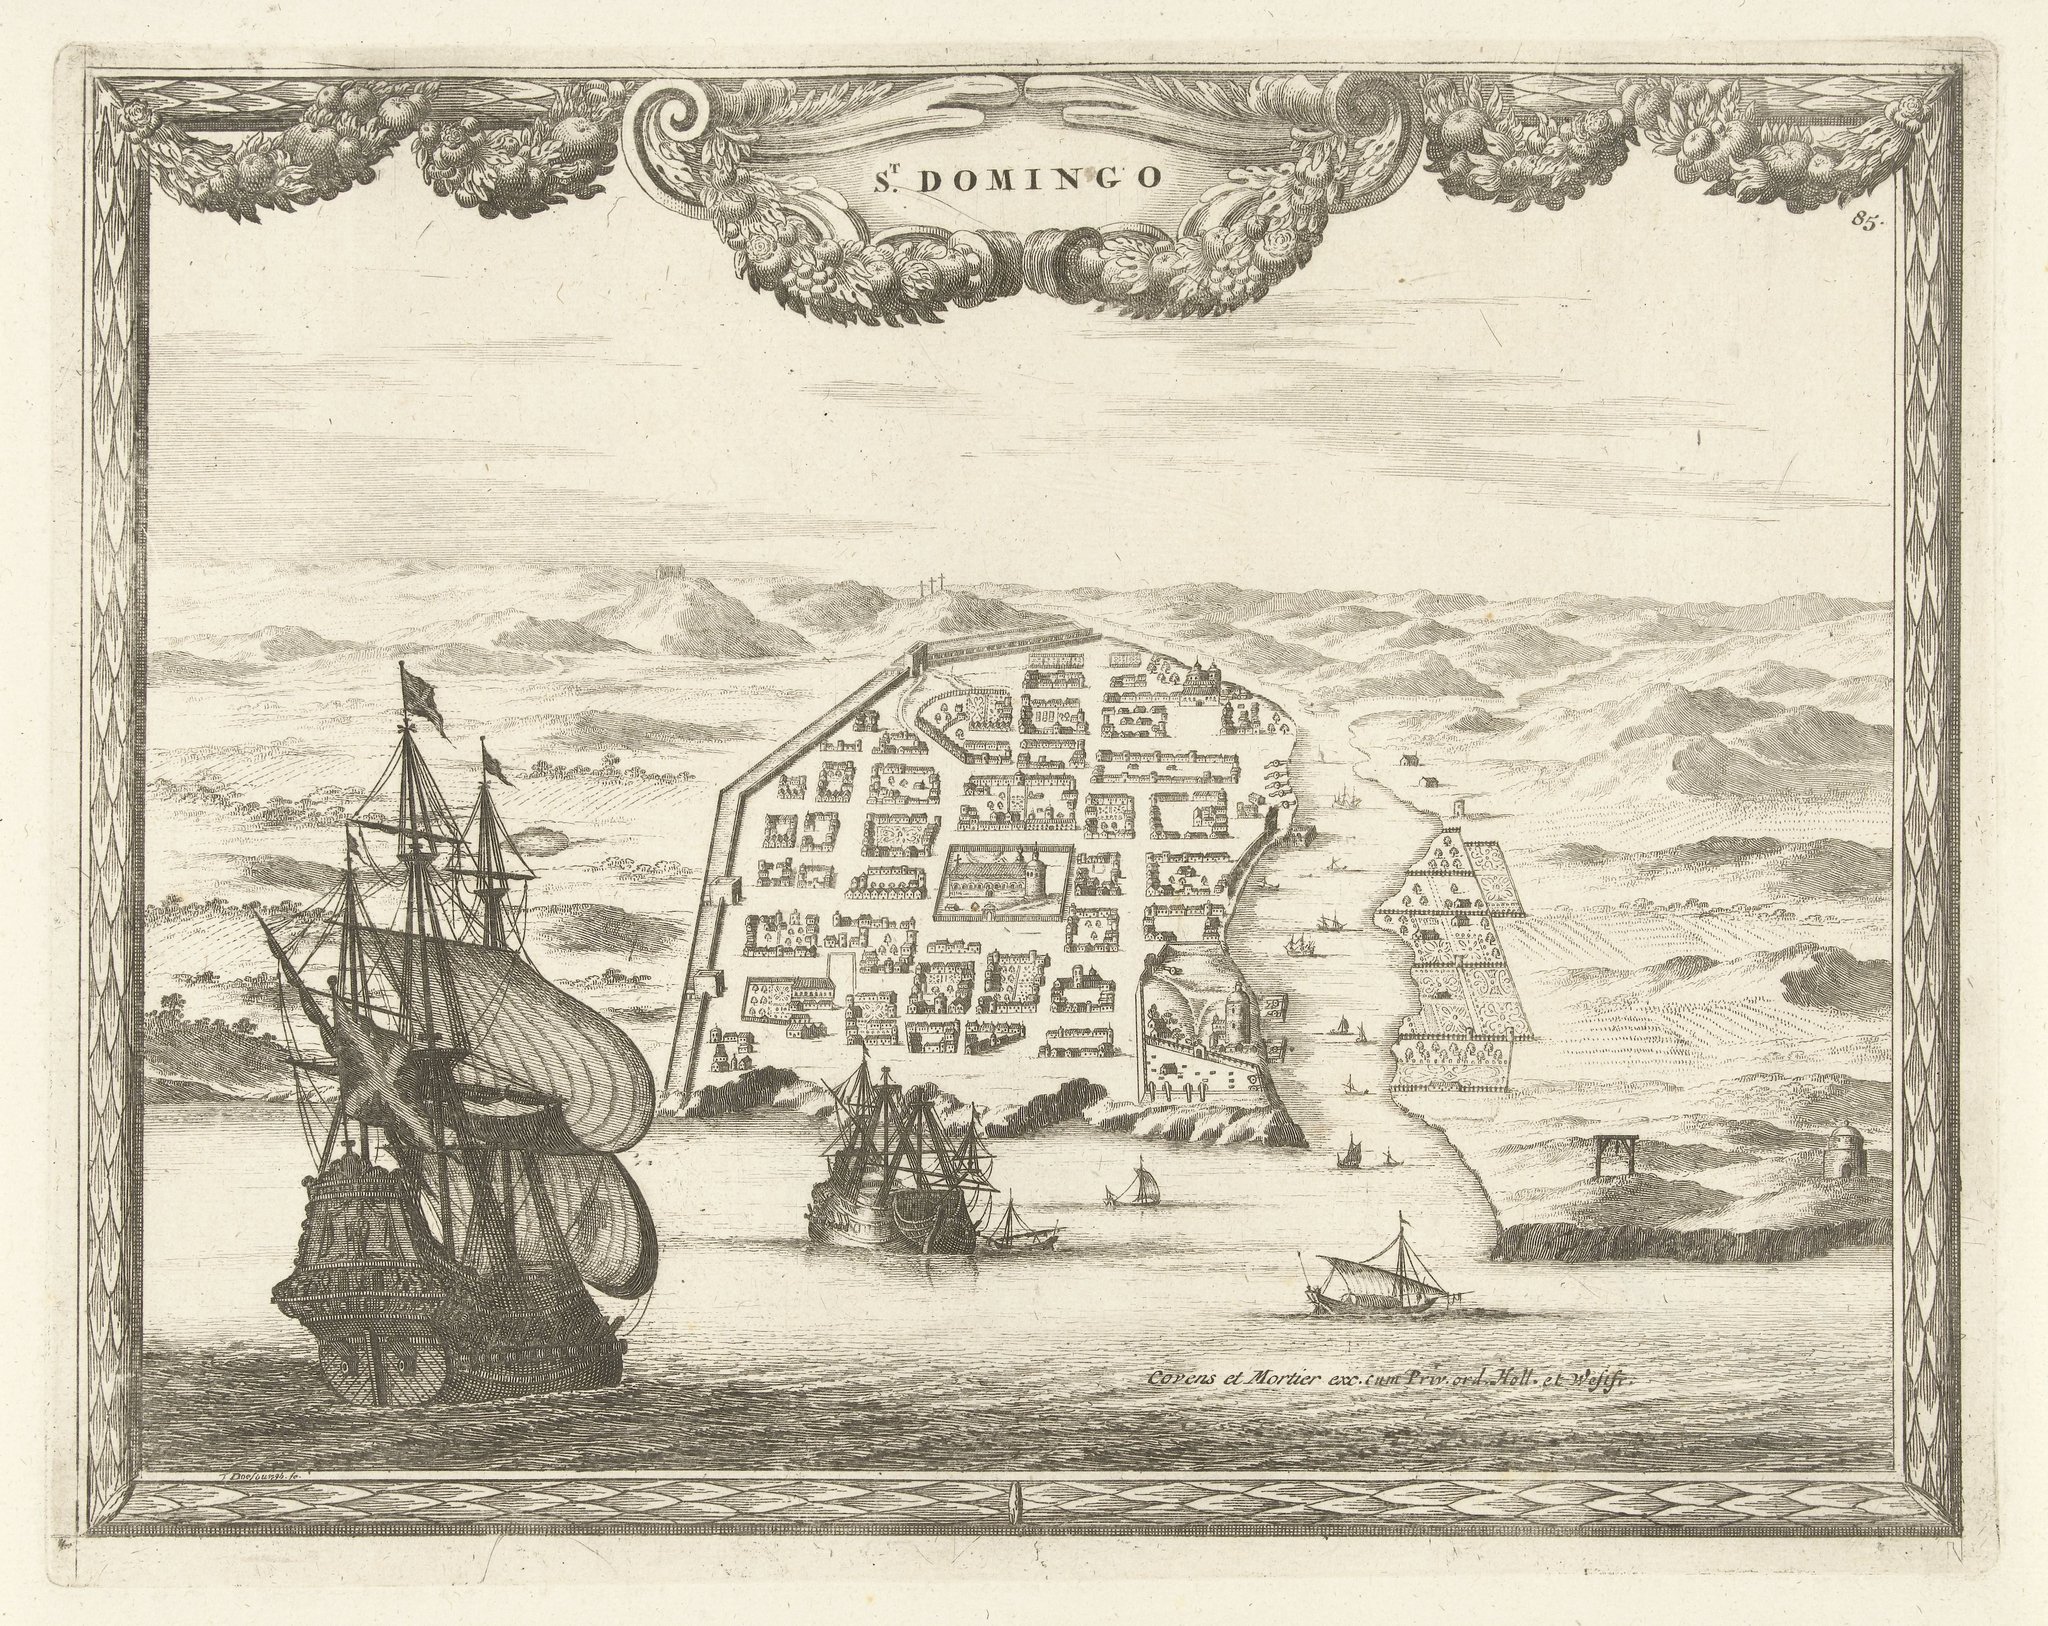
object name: print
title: Des bewoonden waerelds steden en dragten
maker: thomas doesburgh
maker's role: print maker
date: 1685-1714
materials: paper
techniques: etching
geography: amsterdam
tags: merchant shipping, shipping trade, prospect of city, town panorama, silhouette of city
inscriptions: collector's mark: Lugt 2228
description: Prent ook gebuikt voor: Orbis habitabilis oppida et vestitus. Des bewoonden waerelds steden en dragten, Amsterdam, Carel Allard, ca. 1685. Deze prent uit latere uitgave van Johannes Covens en Cornelis Mortier te Amsterdam, plaat 85.